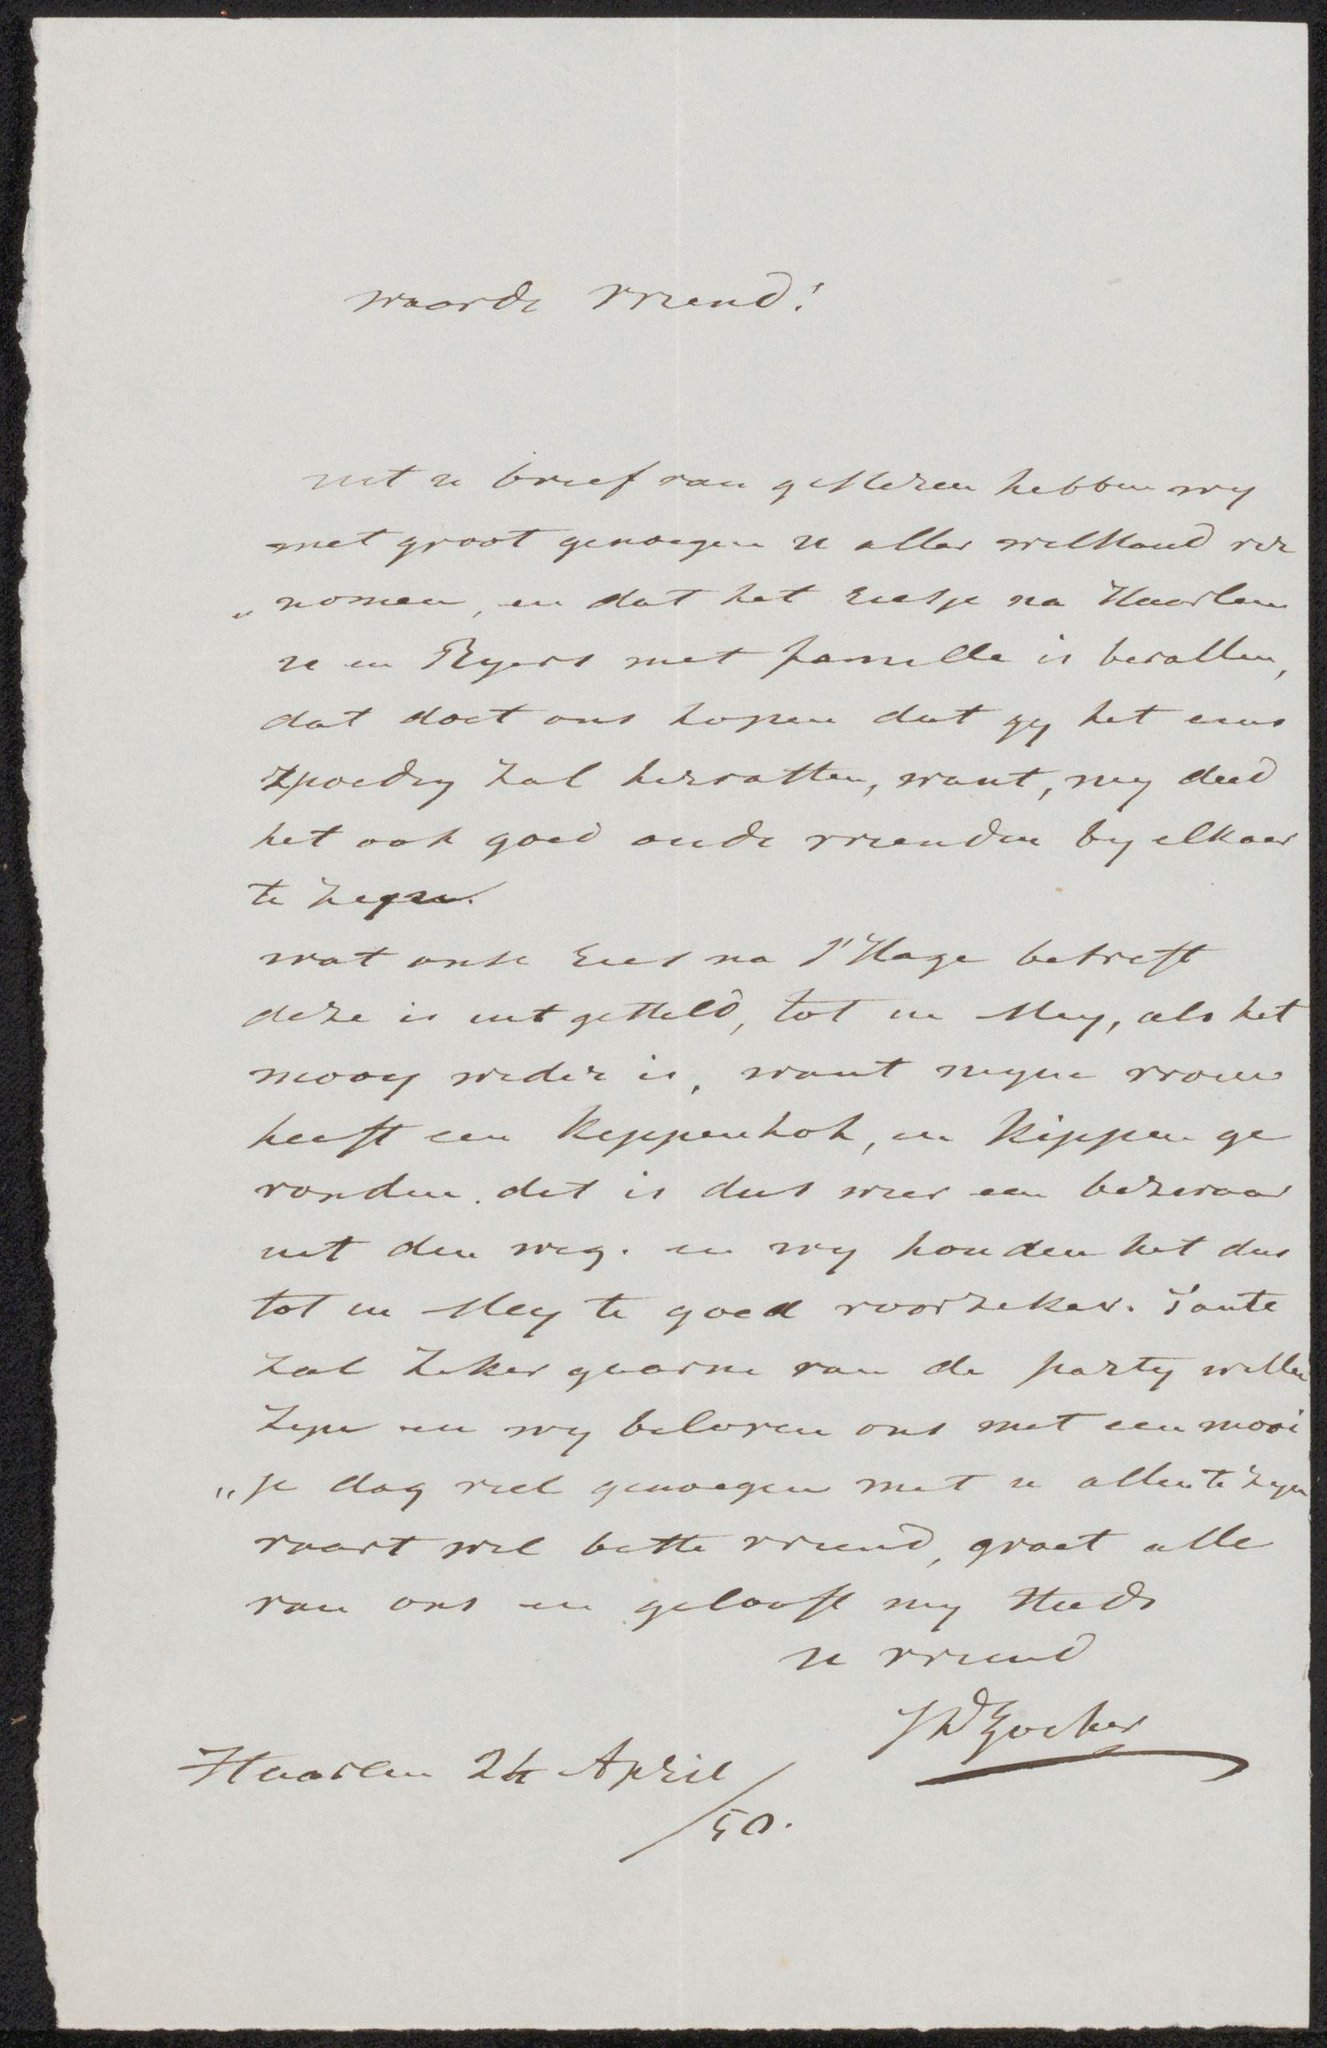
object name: letter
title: Brief aan anoniem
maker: johan david zocher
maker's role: designer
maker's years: 1791-1870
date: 1850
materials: ink, paper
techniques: pen, writing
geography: haarlem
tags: family life, the hague, haarlem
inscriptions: watermark